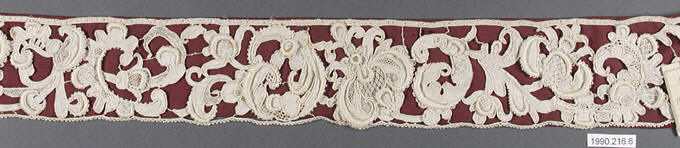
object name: edging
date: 1601-1700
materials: linen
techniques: lace